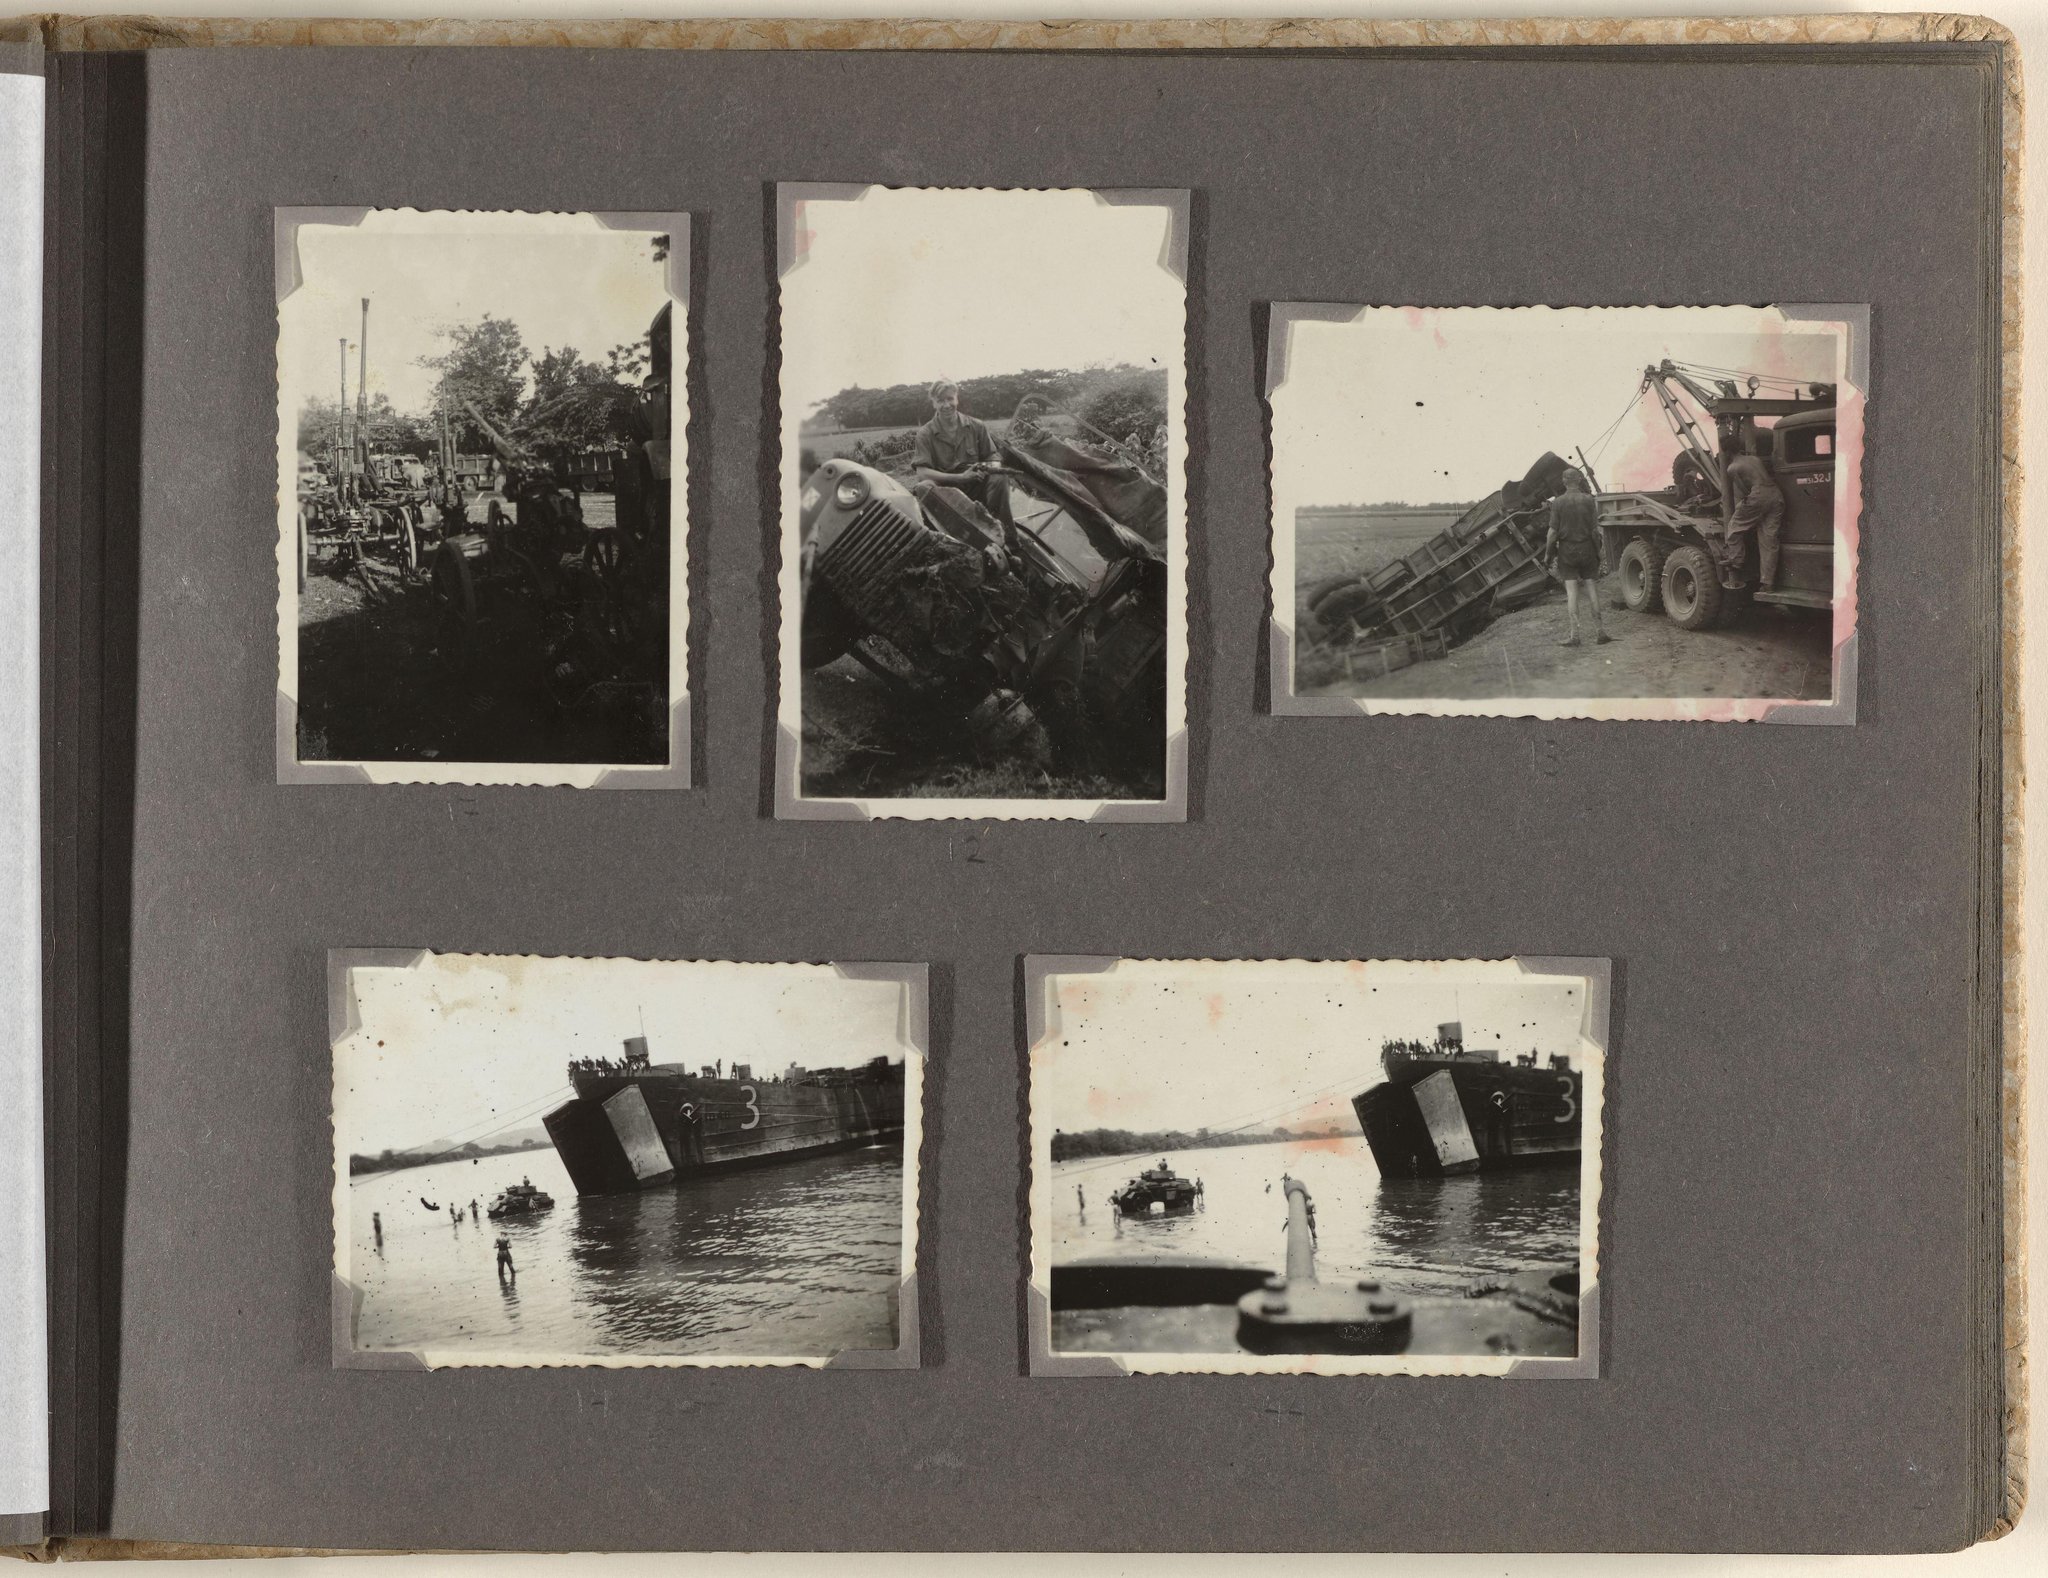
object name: photograph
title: Verongelukte vrachtauto en landingsvaartuig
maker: Anonymous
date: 1946-1949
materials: cardboard, photographic support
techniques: gelatin silver print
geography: dutch east indies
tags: colonial system, military service, modern forms of military vehicles, accident with truck, van, amphibian vehicle, firearms, dutch east indies, the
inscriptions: inscription: ‘Geschut van T.N.I. bij brug Kali Solo / Tasik Madoe.’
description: Albumblad met vijf foto's: buitgemaakt geschut van TNI in Solo, het takelen van een verongelukte militaire vrachtauto bij Tasik Madoe en het uitrijden van een pantserwagen uit een landingsvaartuig. Onderdeel van het fotoalbum over de diensttijd van Nederlandse militairen in Indië, ca. 1946-1949.